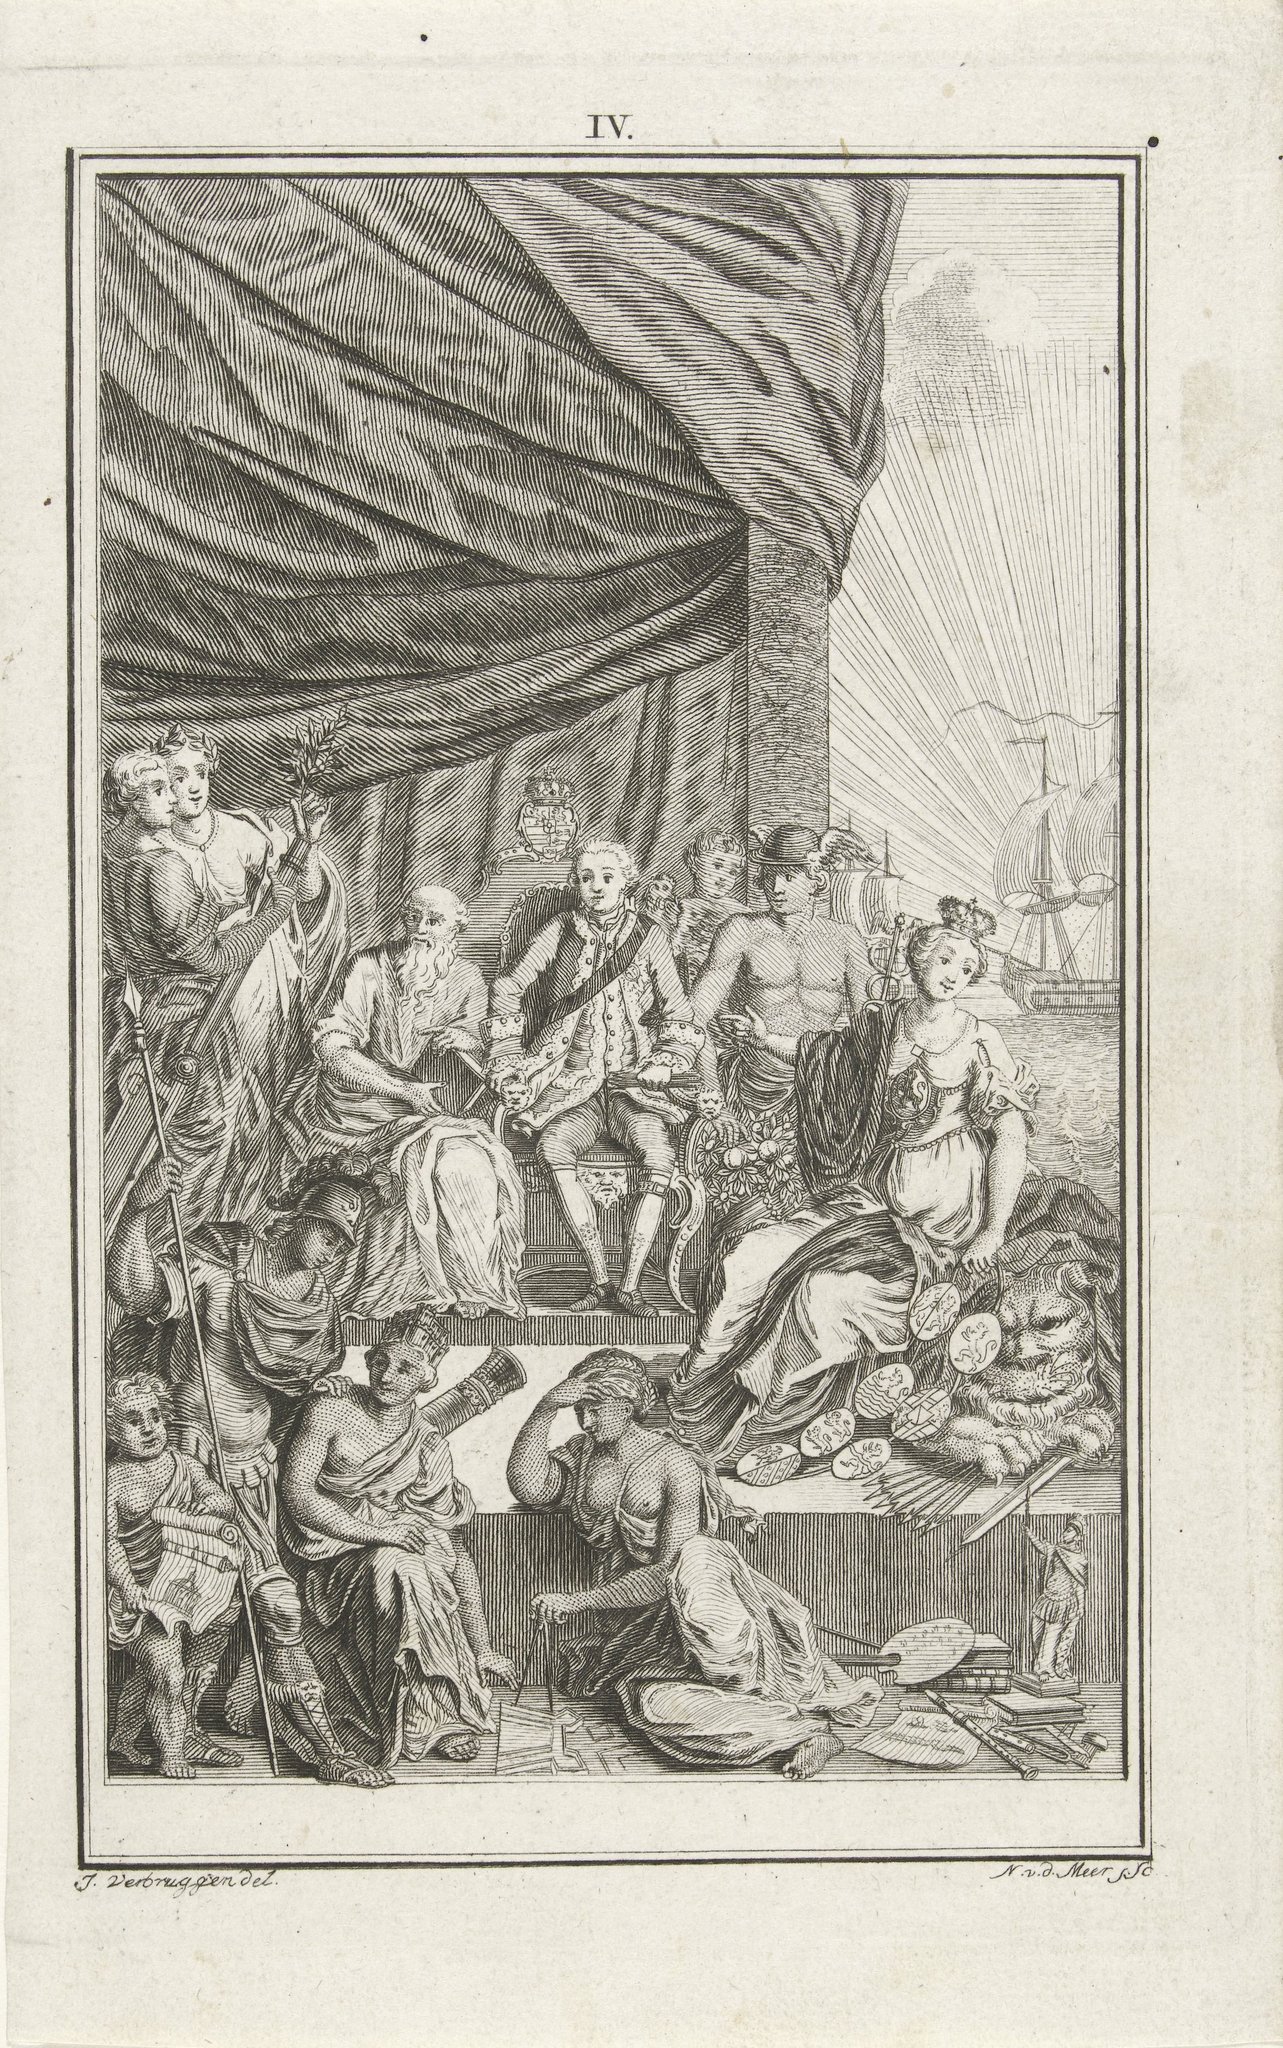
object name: print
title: Allegorie op de verheffing van Willem IV tot stadhouder in 1747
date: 1747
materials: paper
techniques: engraving, etching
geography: northern netherlands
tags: willem iv (prins van oranje-nassau), personifications of countries, nations, states, districts, etc., netherlands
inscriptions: collector's mark: Lugt 2228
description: Allegorie op de verheffing van prins Willem IV tot stadhouder in 1747. De prins zittend op een troon omringd door personificaties, waaronder de Nederlandse Maagd, Mercurius, de Vrije Kunsten, Eendracht en de Vrede. Gemerkt bovenaan: IV.